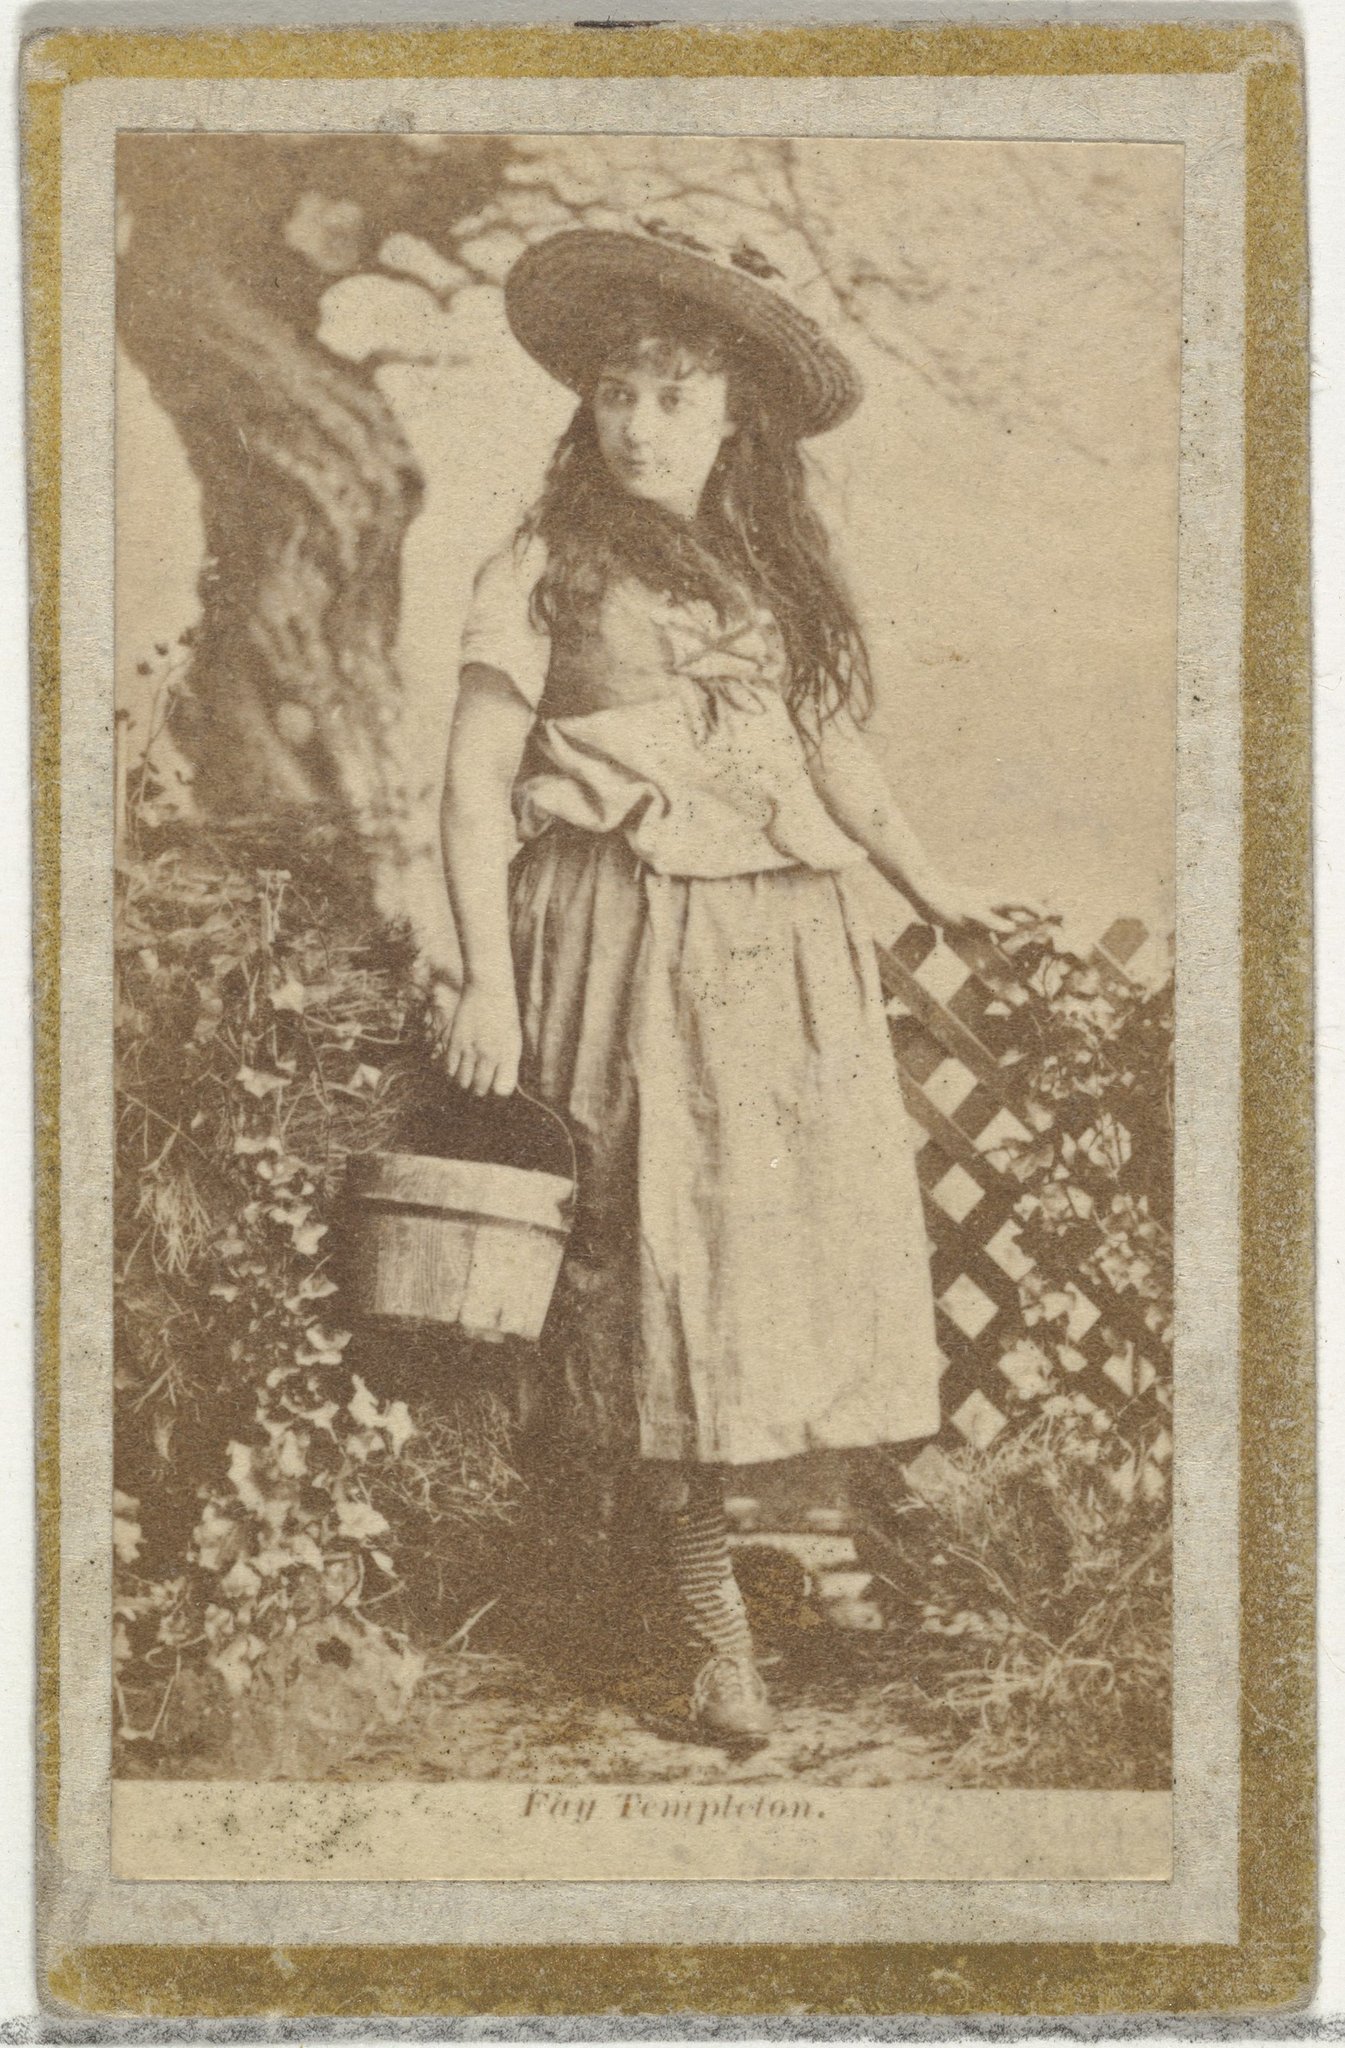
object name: photograph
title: Fay Templeton, from the Actresses and Celebrities series (N60, Type 2) promoting Little Beauties Cigarettes for Allen & Ginter brand tobacco products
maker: allen & ginter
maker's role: publisher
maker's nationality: american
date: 1887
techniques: albumen silver print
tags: portraits,women,actresses